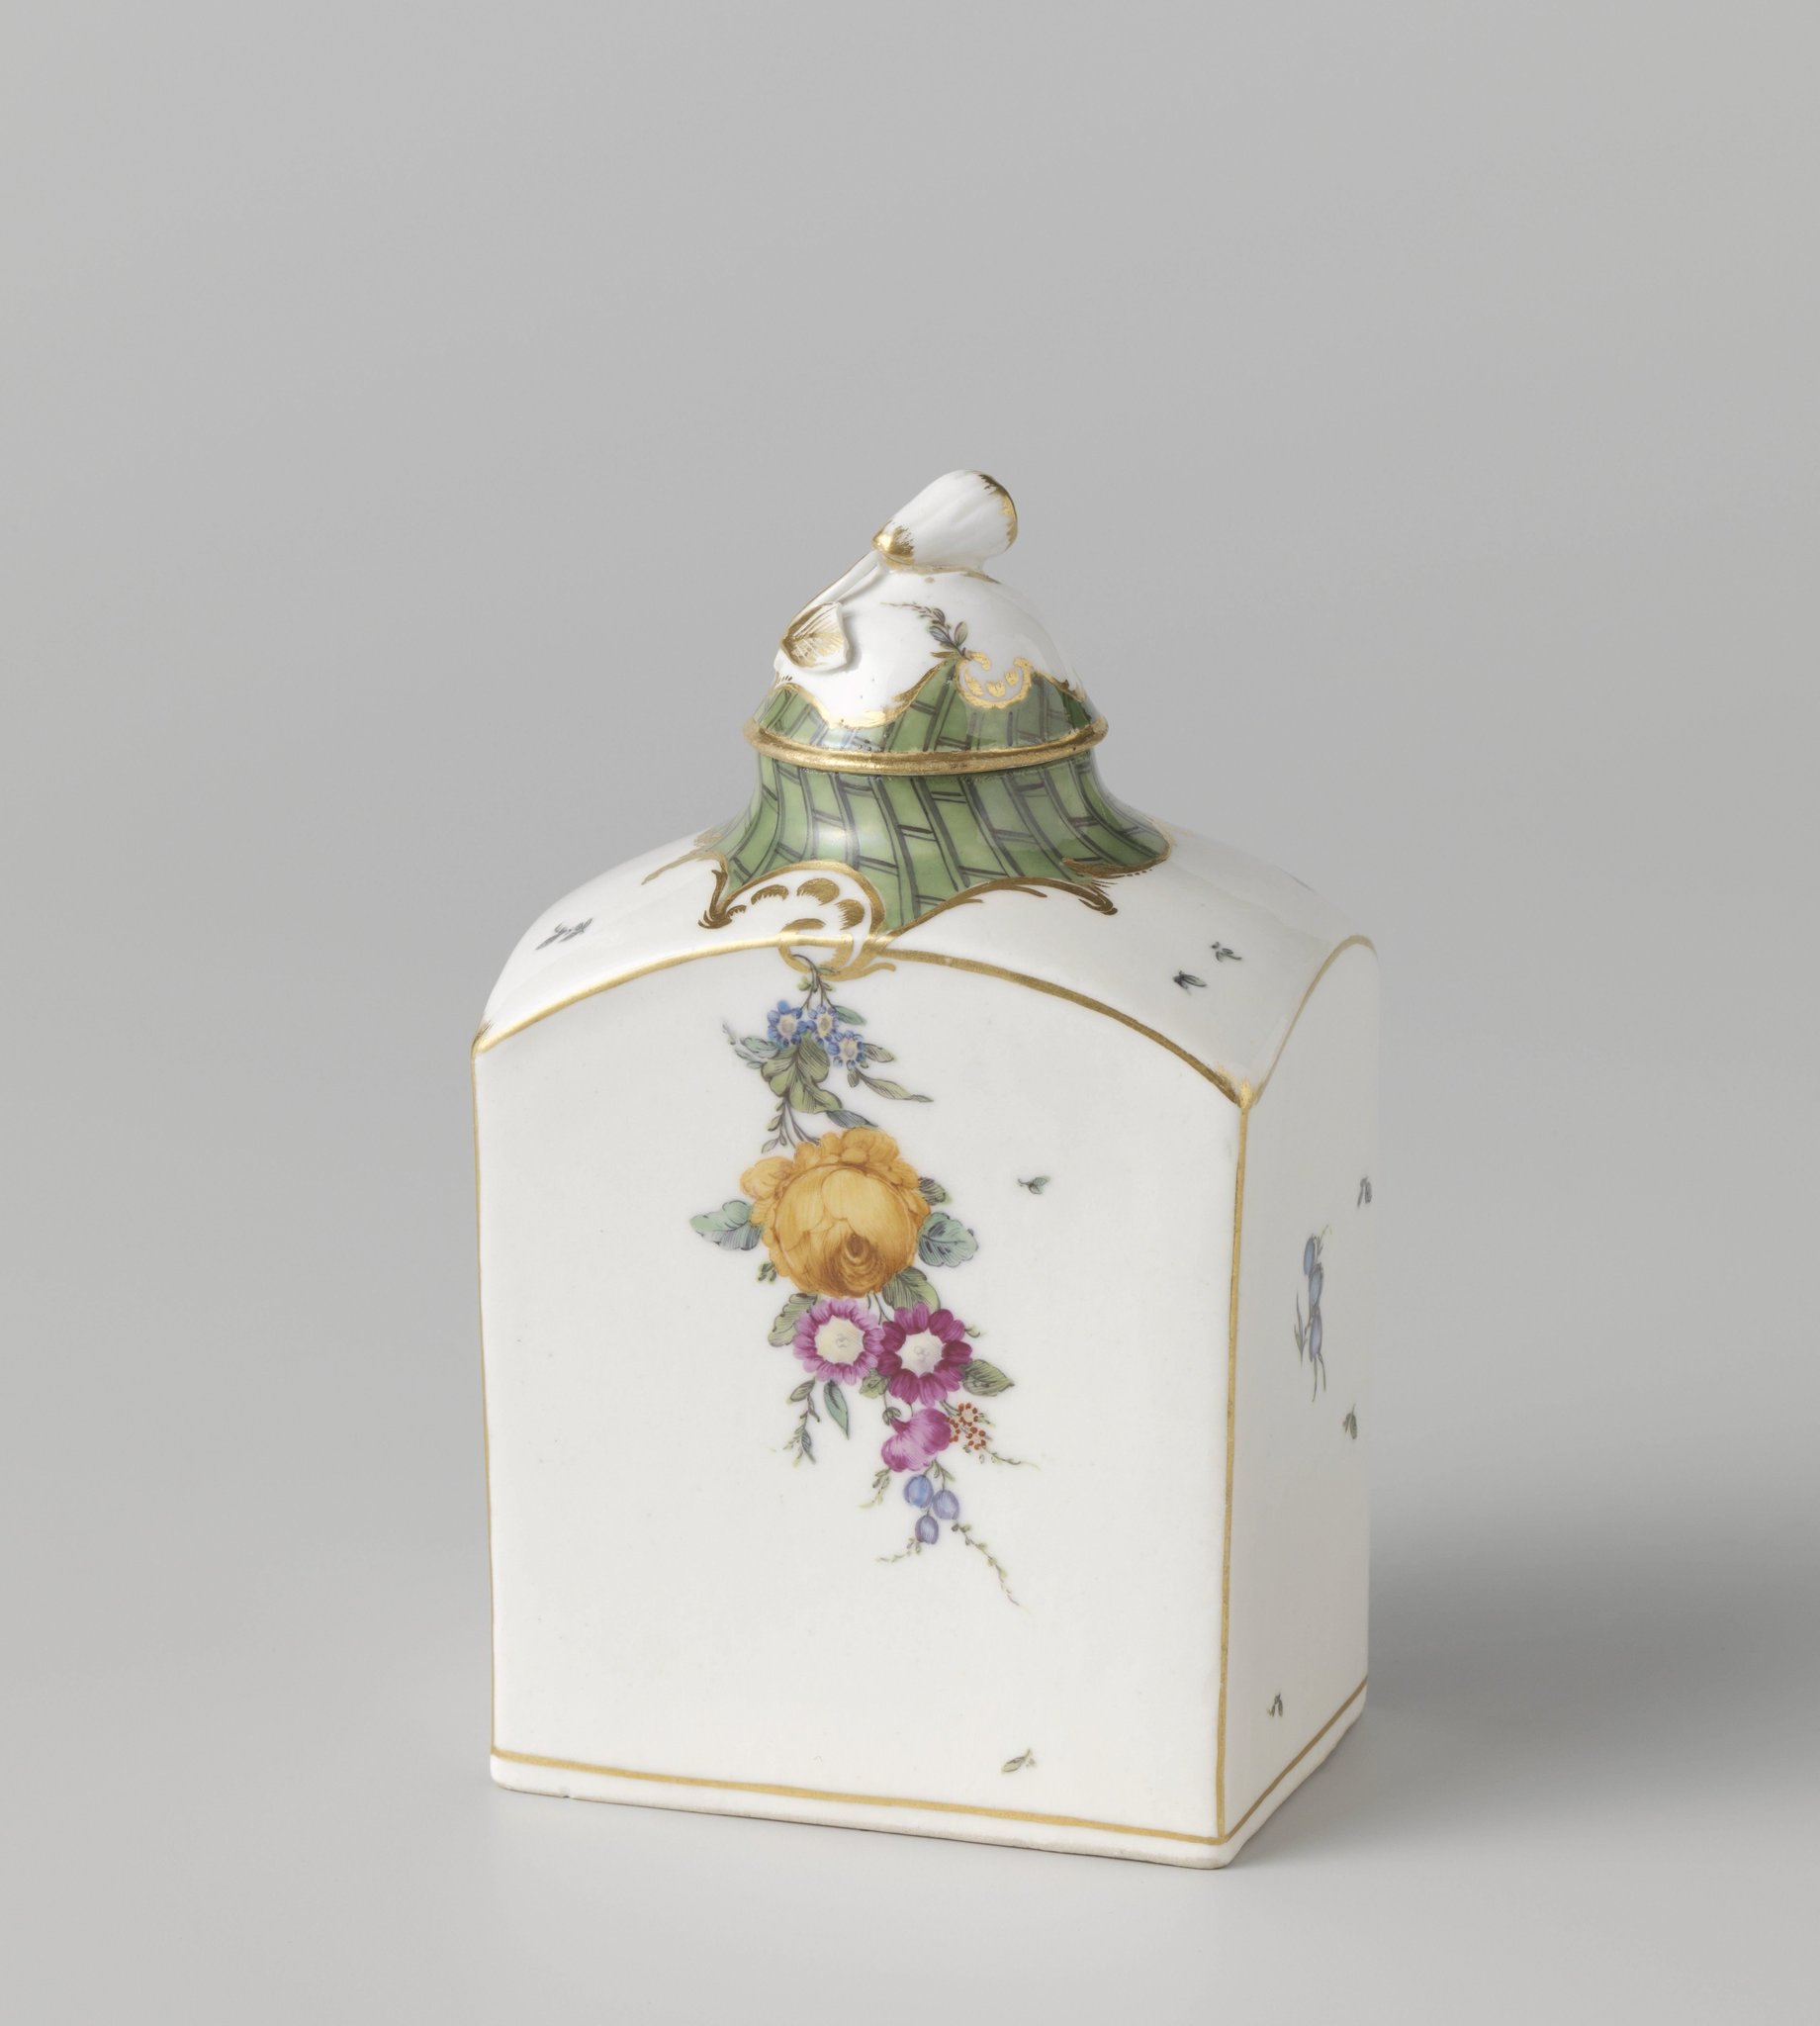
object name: tea caddy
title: Theebus, beschilderd met bloemen en laddermotief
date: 1775-1778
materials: porcelain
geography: loosdrecht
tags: flowers ~ ornament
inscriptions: mark: ‘L1’, factory mark: ‘M:OL’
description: Theebus van porselein. Beschilderd met bloemen en een laddermotief in heldere kleuren.